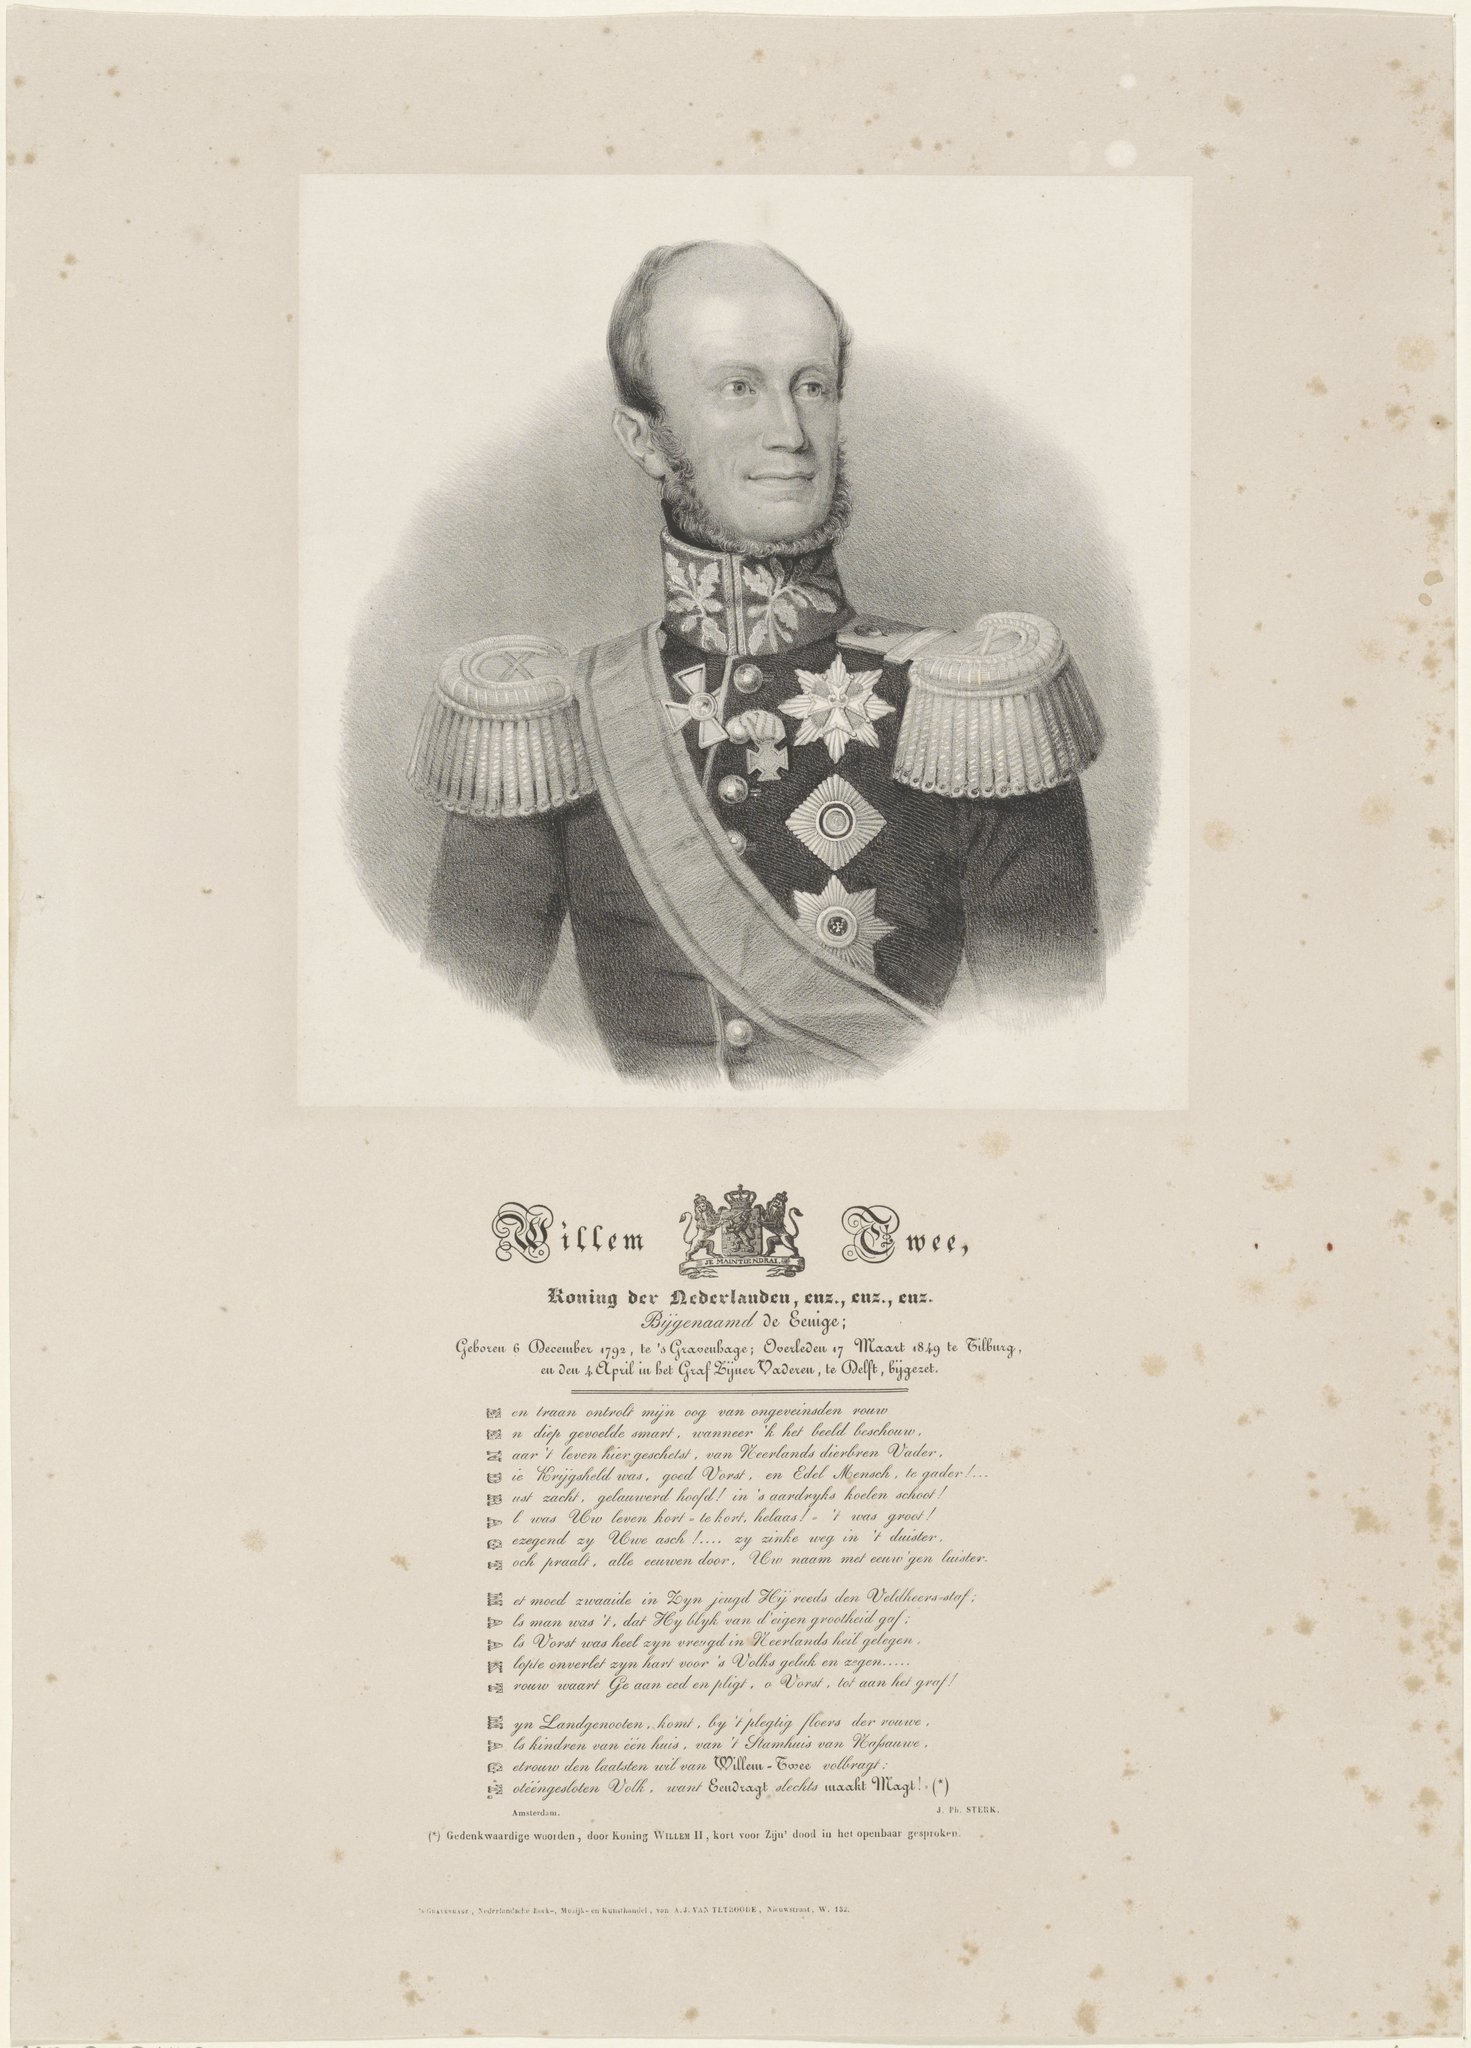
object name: print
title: Portret van Willem II, koning der Nederlanden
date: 1849-1875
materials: paper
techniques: lithograph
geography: netherlands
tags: the hague, william ii of the netherlands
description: De hier vermelde titel verwijst naar de hoogst verkregen titel van de geportretteerde, niet per se naar de titel die de geportretteerde op deze voorstelling draagt.